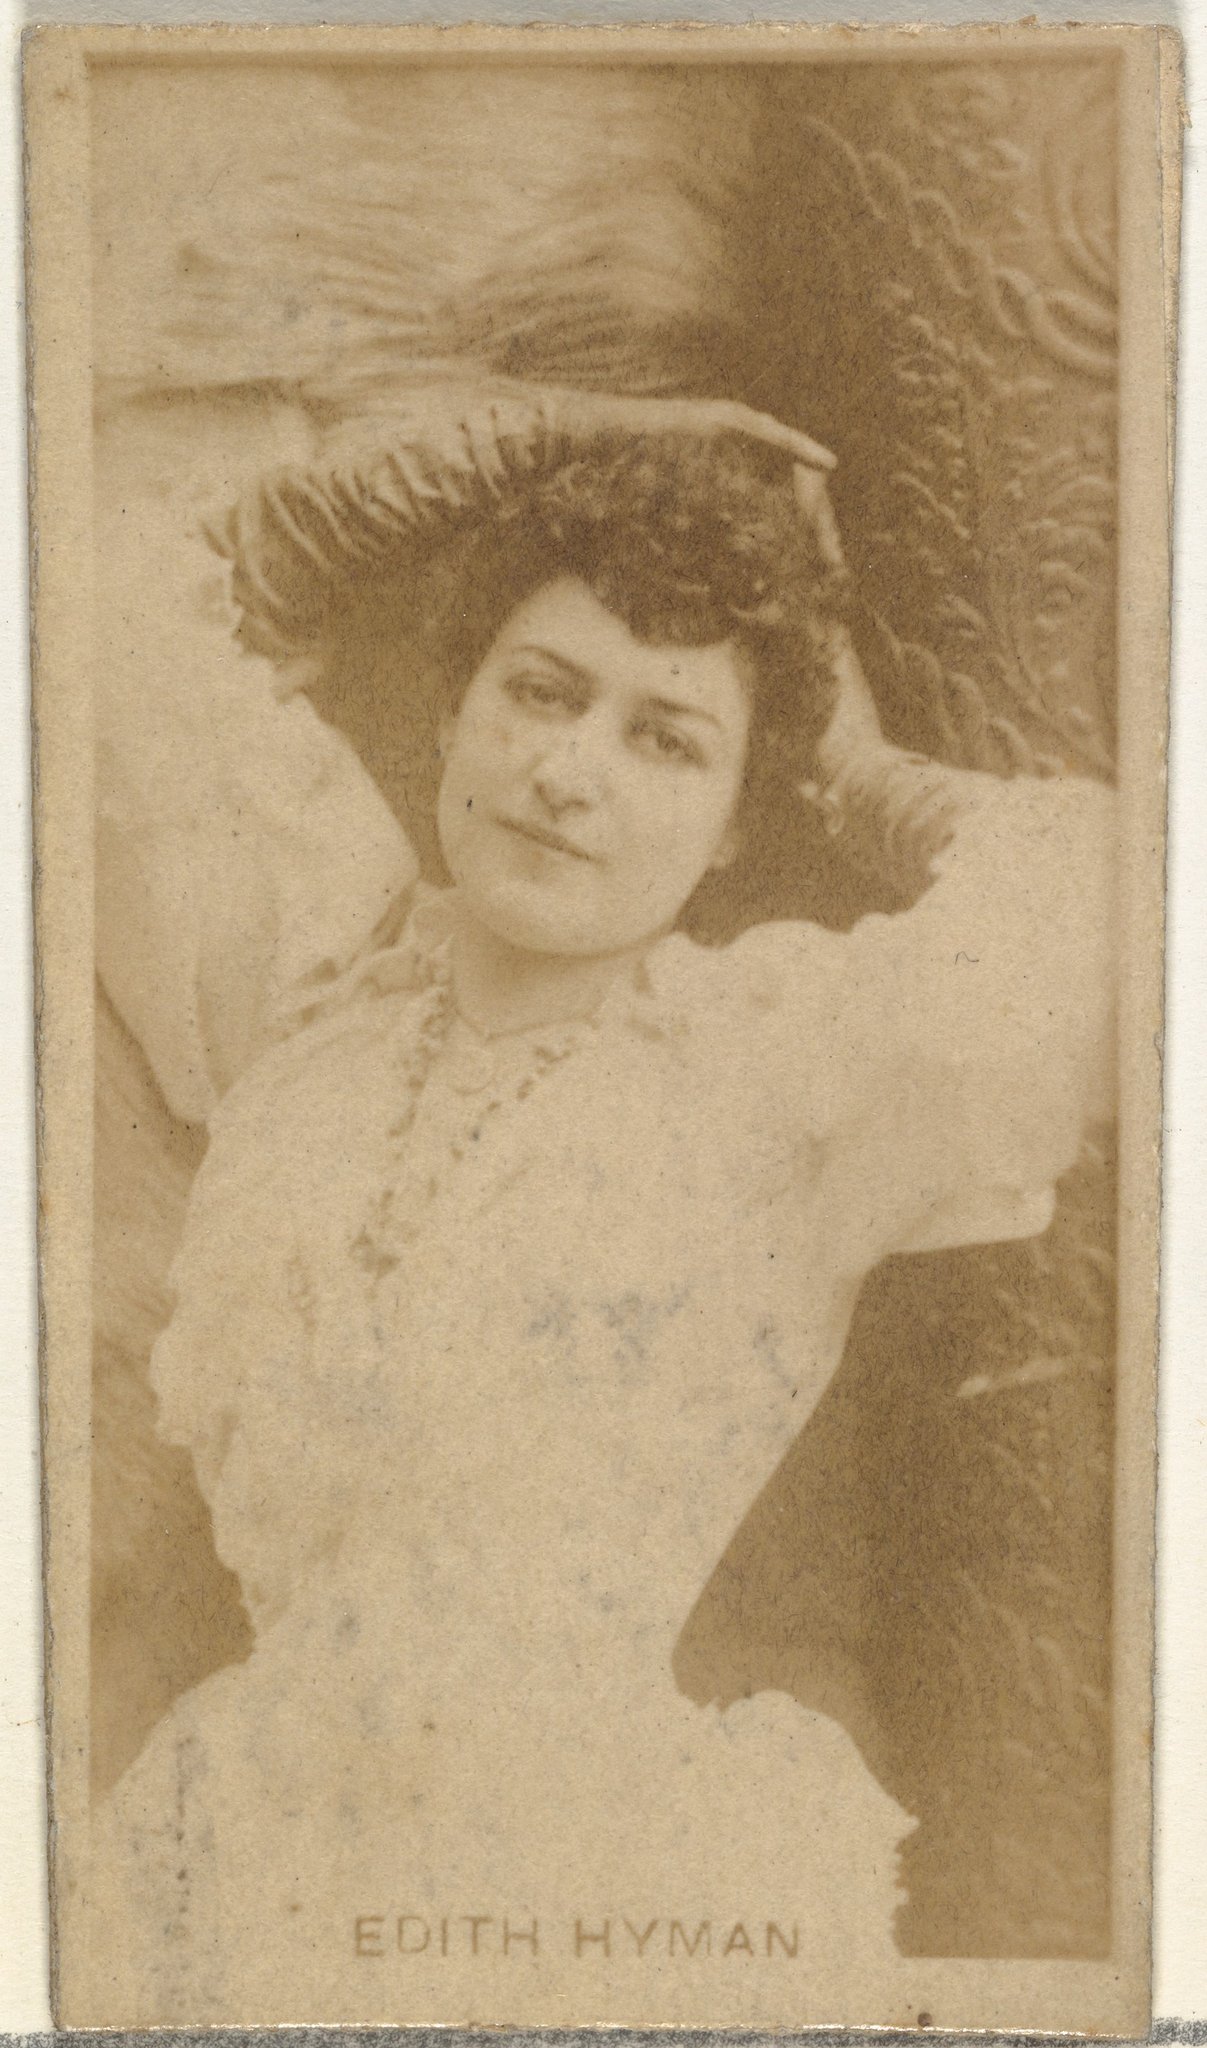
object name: photograph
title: Edith Hyman, from the Actors and Actresses series (N145-8) issued by Duke Sons & Co. to promote Duke Cigarettes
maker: w. duke, sons & co.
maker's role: publisher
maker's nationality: american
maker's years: 1870-1920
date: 1891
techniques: albumen silver print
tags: portraits,women,actresses